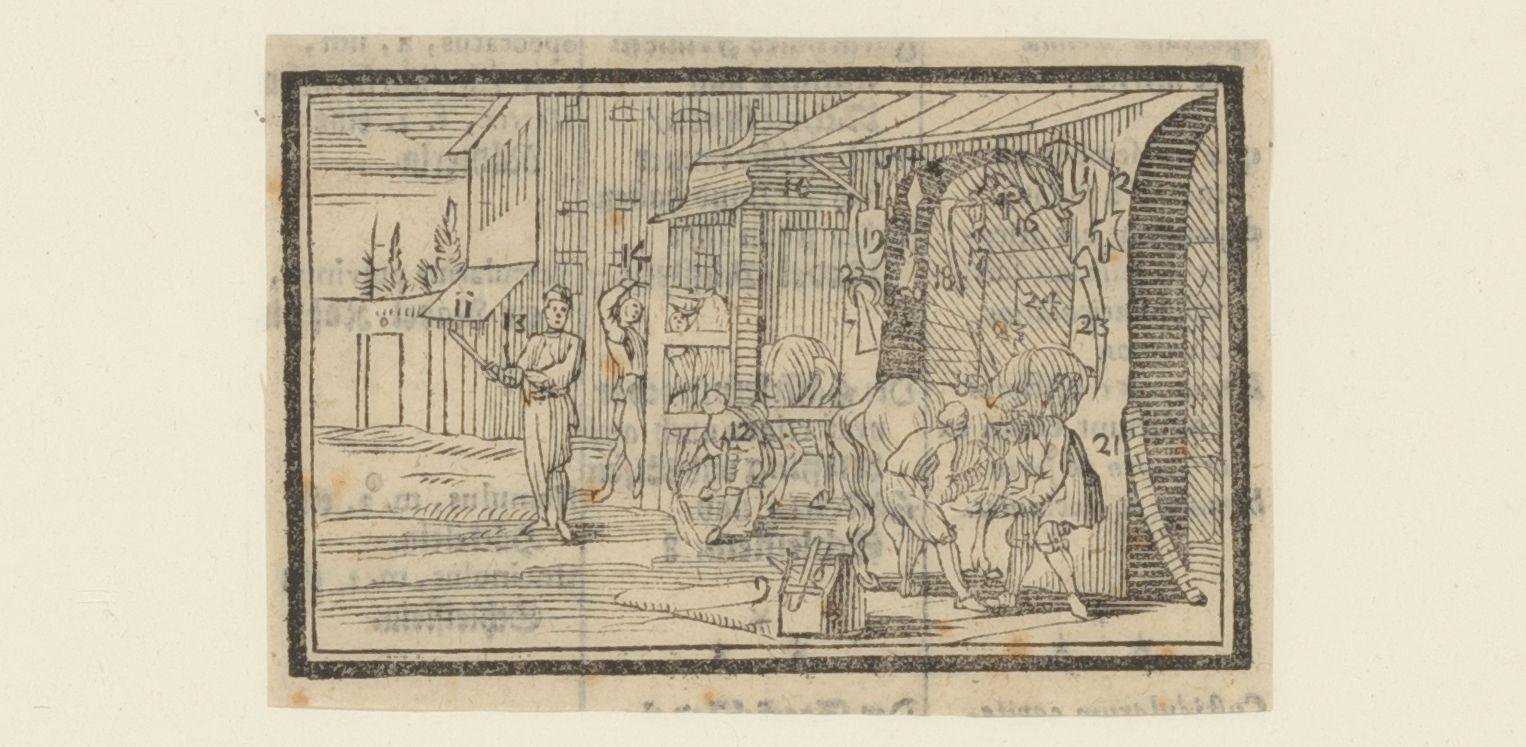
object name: book illustration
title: IJzerwerkers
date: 1719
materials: paper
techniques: letterpress printing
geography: nuremberg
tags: handicrafts, craftsman at work, other handicrafts ~ metal, smith, blacksmith, iron and steel industry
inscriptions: stamp, collector's mark: Lugt 1641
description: Prent uit: Comenius, Johannes Amosius. Orbis sensualium picti pars prima (...). Neurenberg: Martin Endter, 1719, dl. 2, p. 150. Prent eerder gebruikt in: Comenius, Johannes Amosius. Orbis Sensualium Picti denuo aucti Pars Secunda (...). Neurenberg: Martin Endter, 1730, dl. 2.